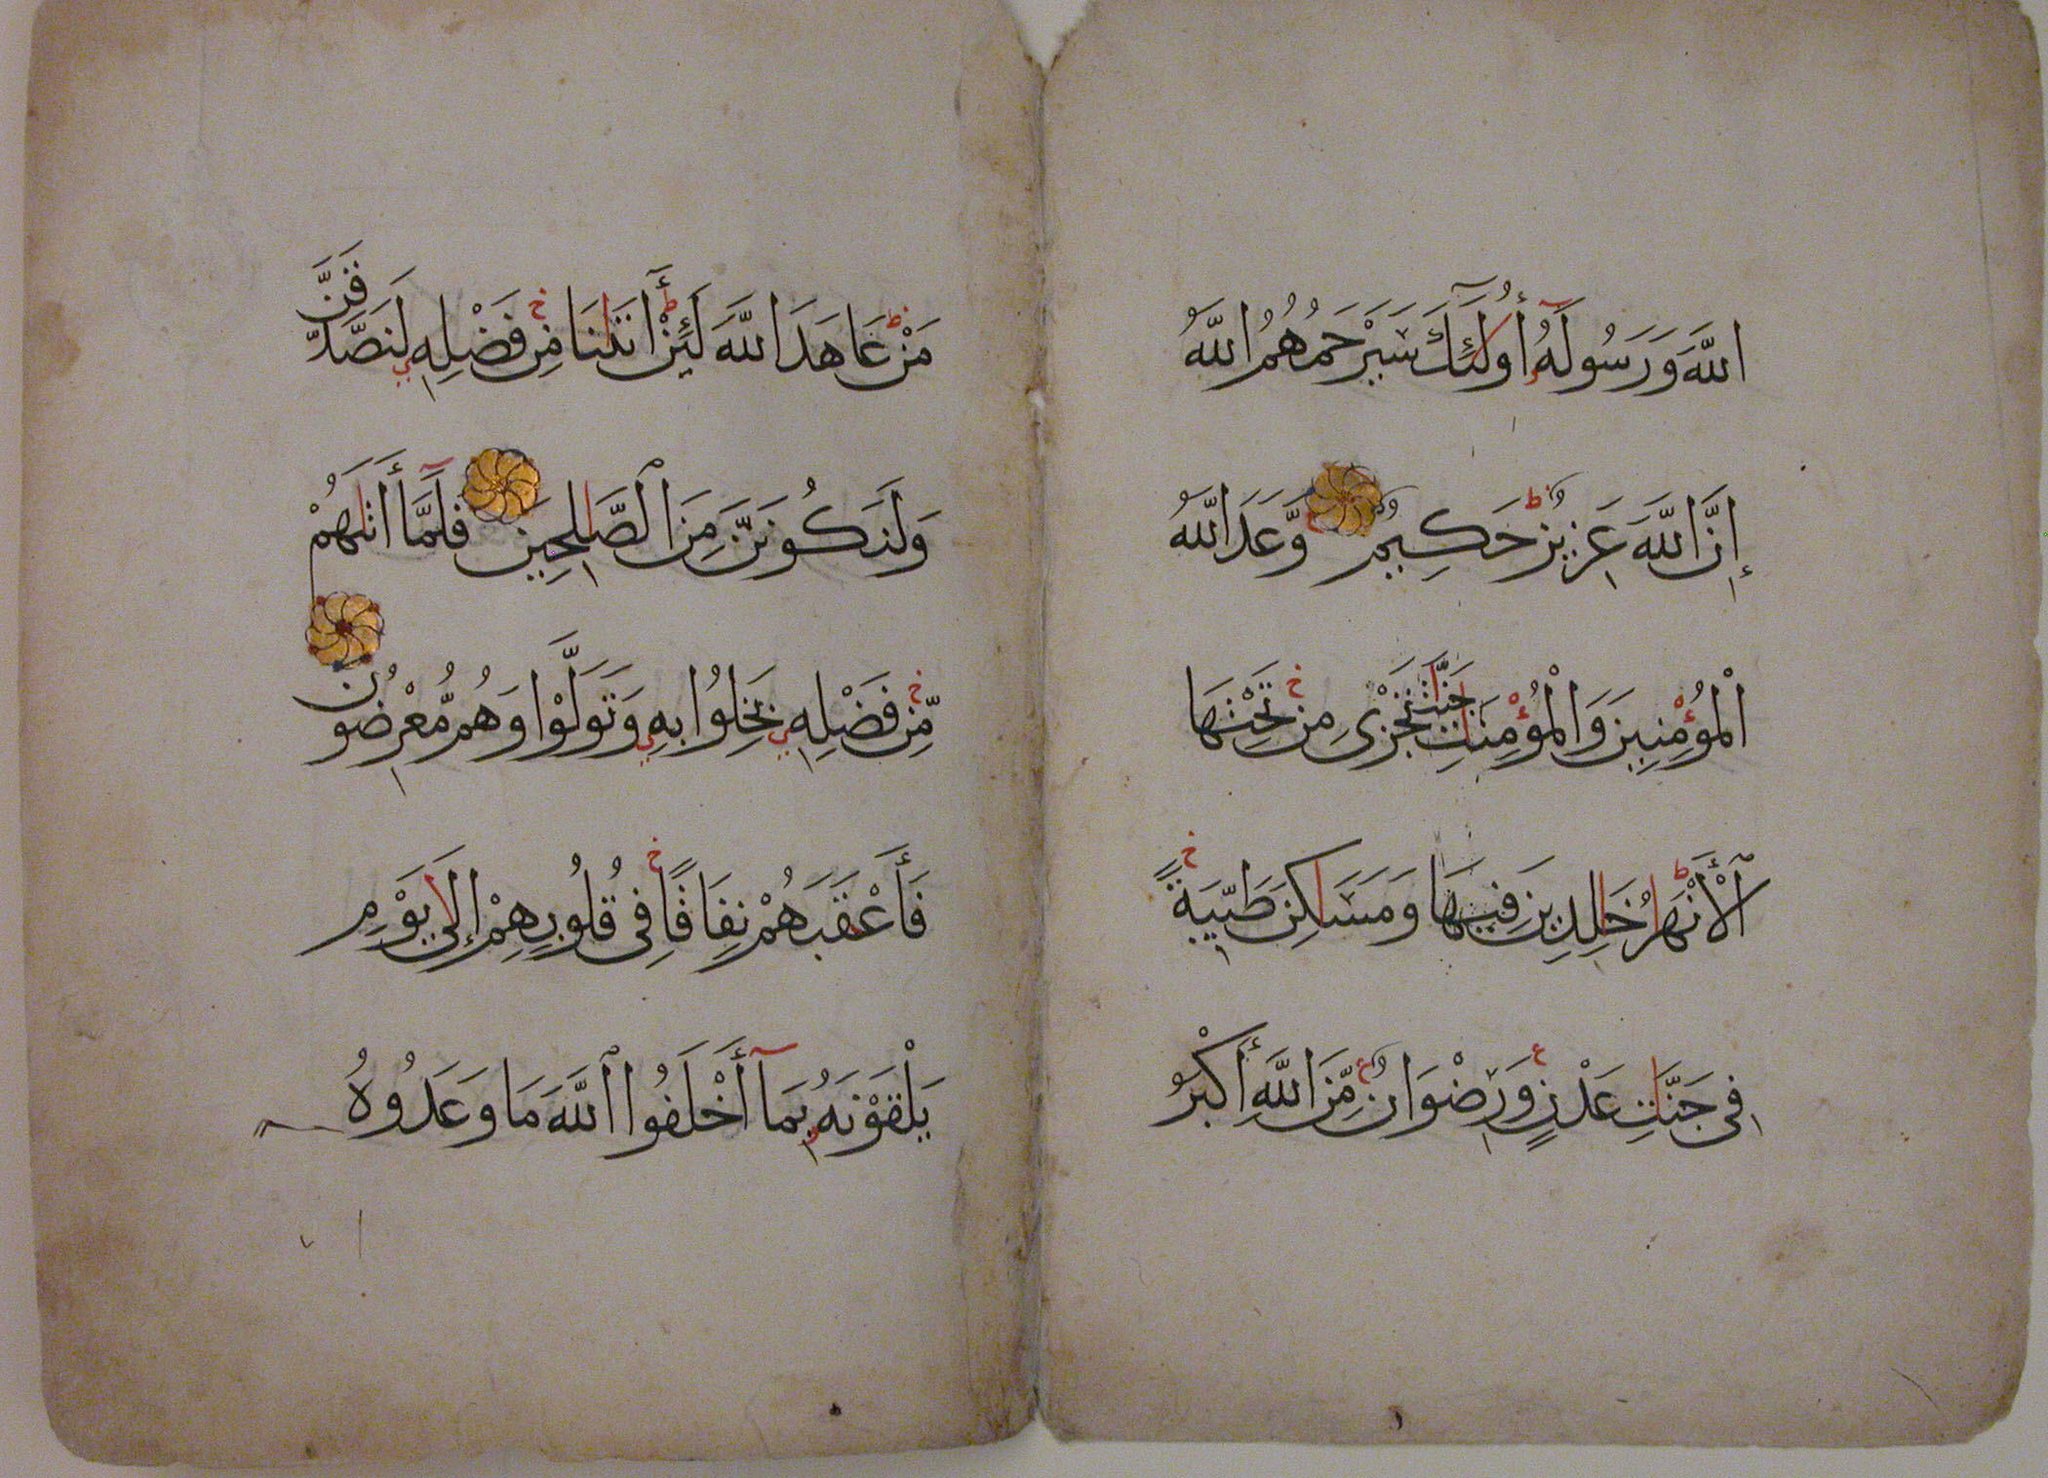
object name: bifolio from a non illustrated manuscript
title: Bifolium from a Qur'an Manuscript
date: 1401-1500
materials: gold, ink, paper, watercolor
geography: egypt or syria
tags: arabic,qur'an,calligraphy